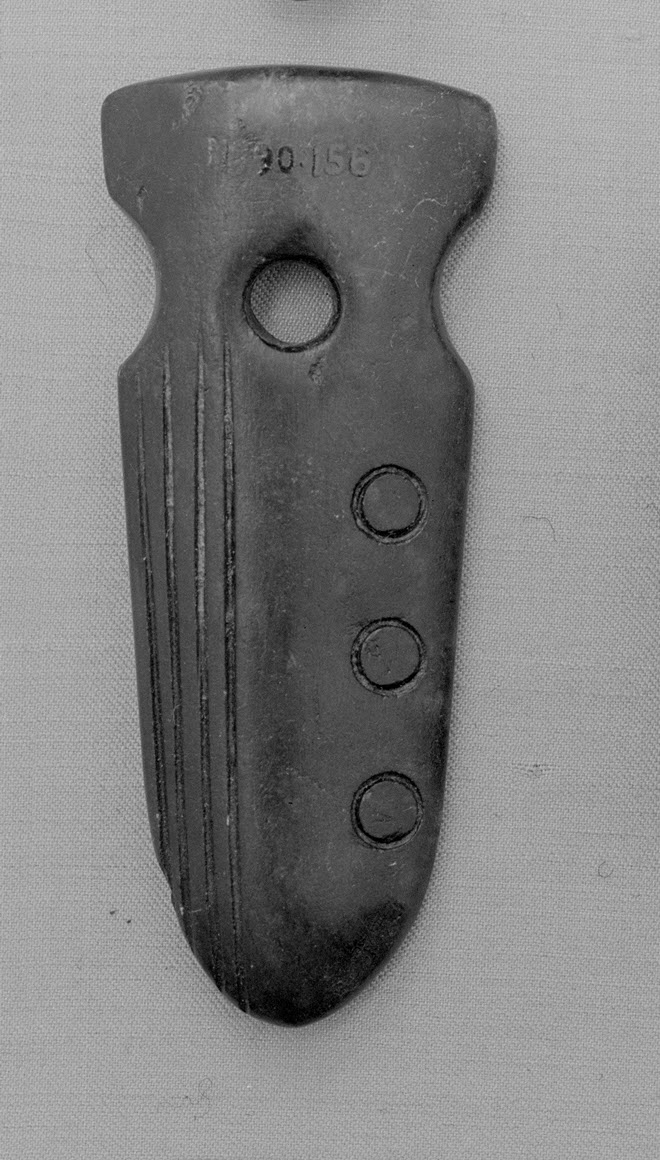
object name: necklace, bead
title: Amulet (Tongue?)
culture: chinese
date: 206 BCE-220 CE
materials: jade